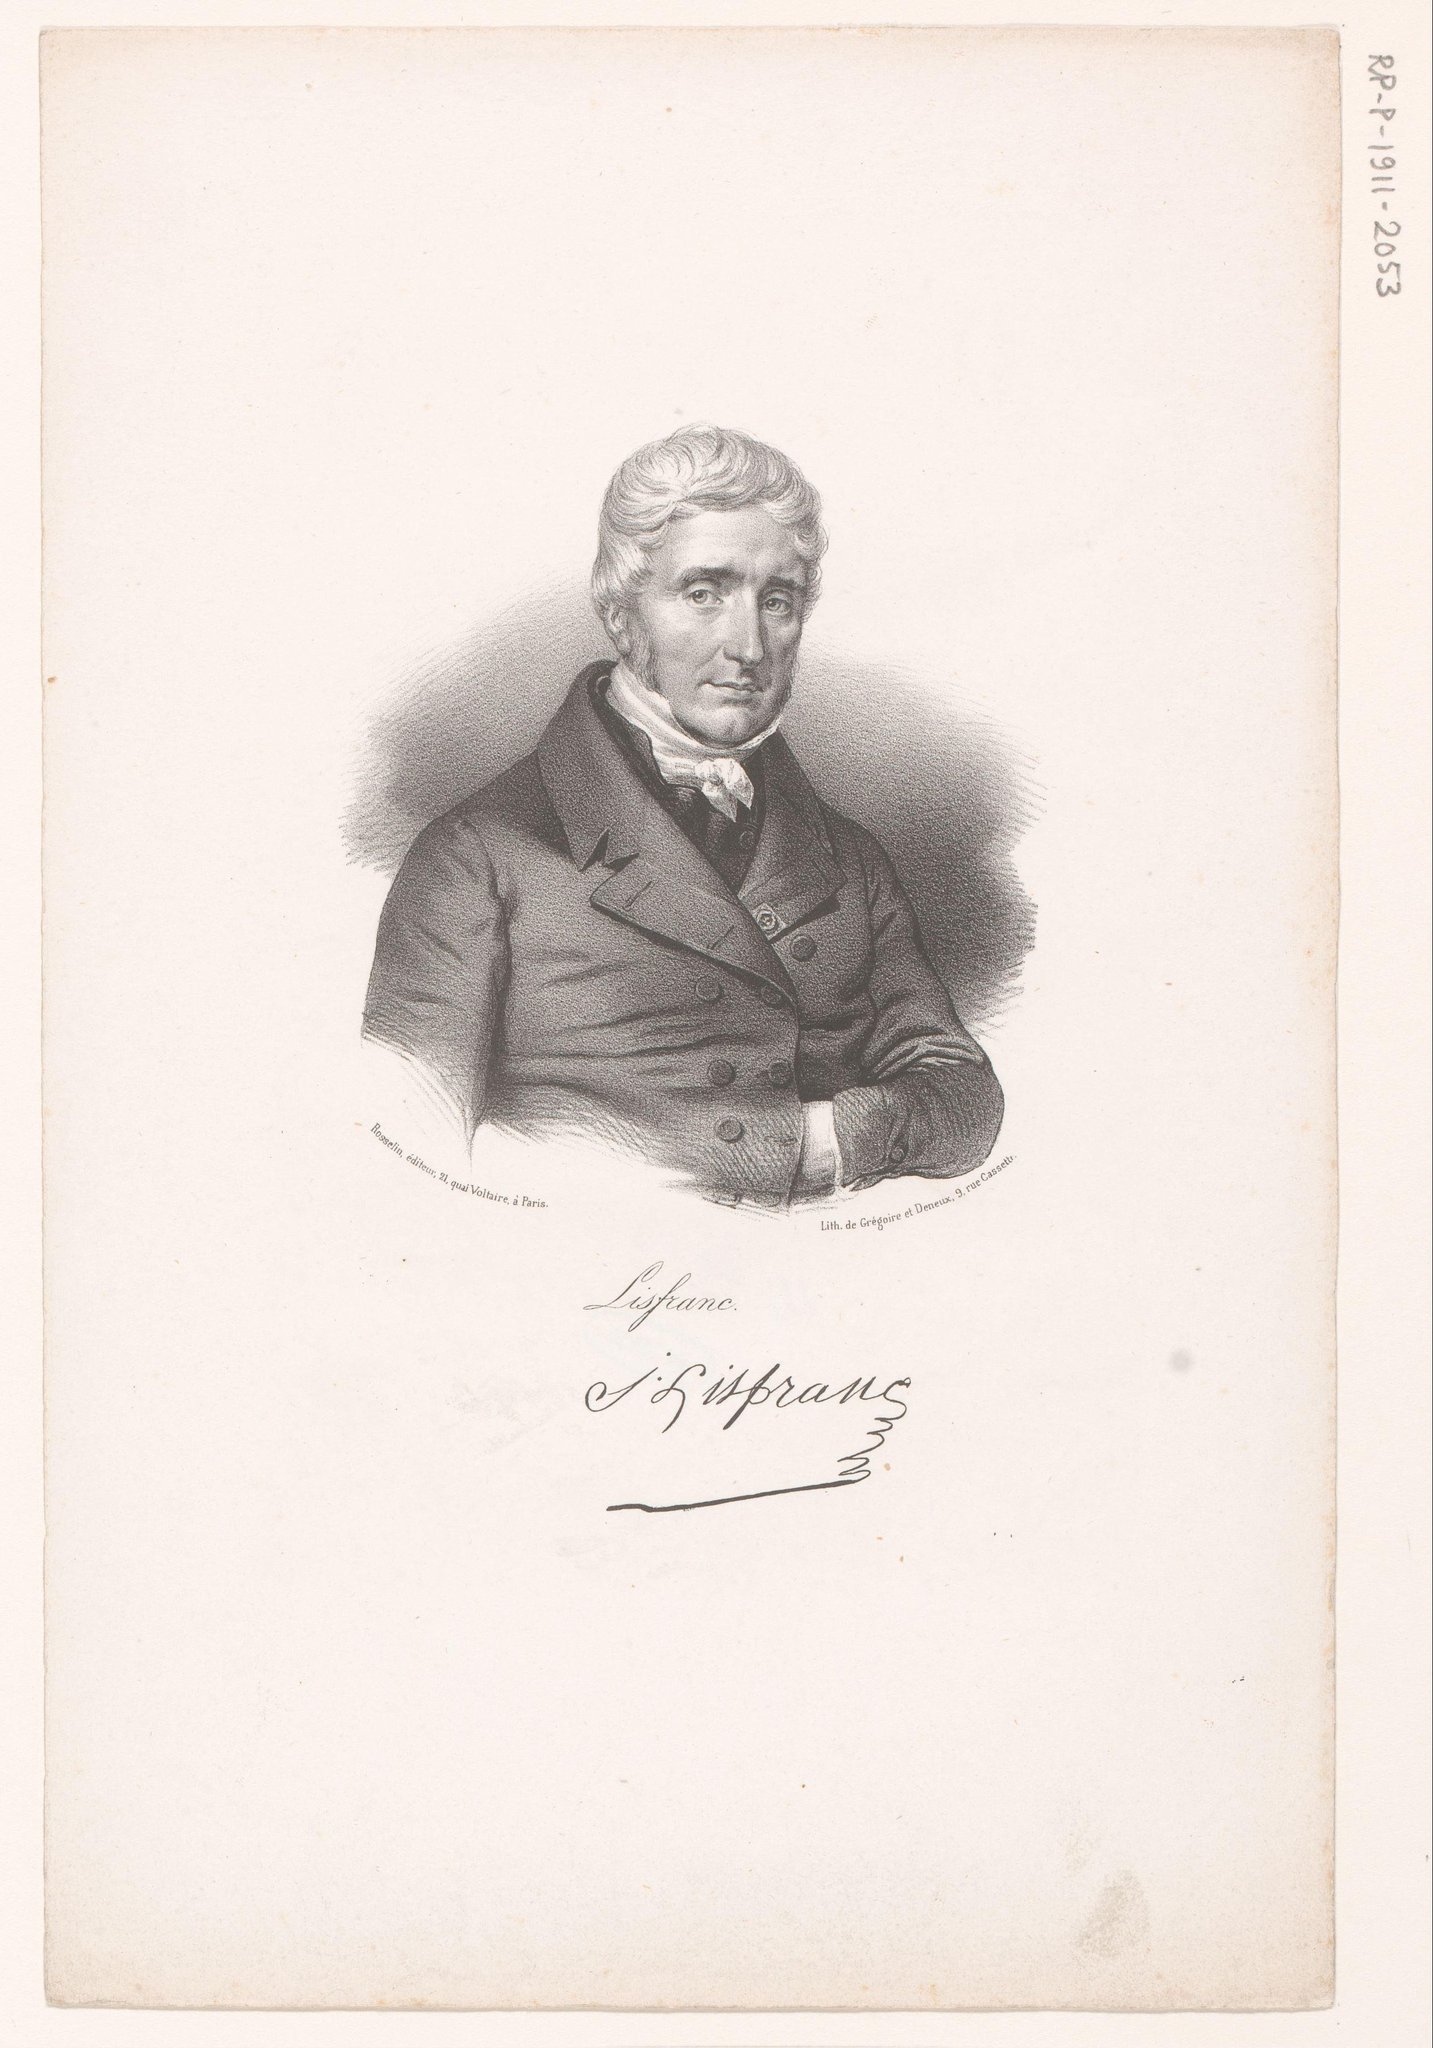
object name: print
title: Portret van Jacques Lisfranc de Saint Martin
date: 1844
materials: paper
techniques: lithograph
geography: paris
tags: paris, historical persons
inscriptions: collector's mark: Lugt 2228a